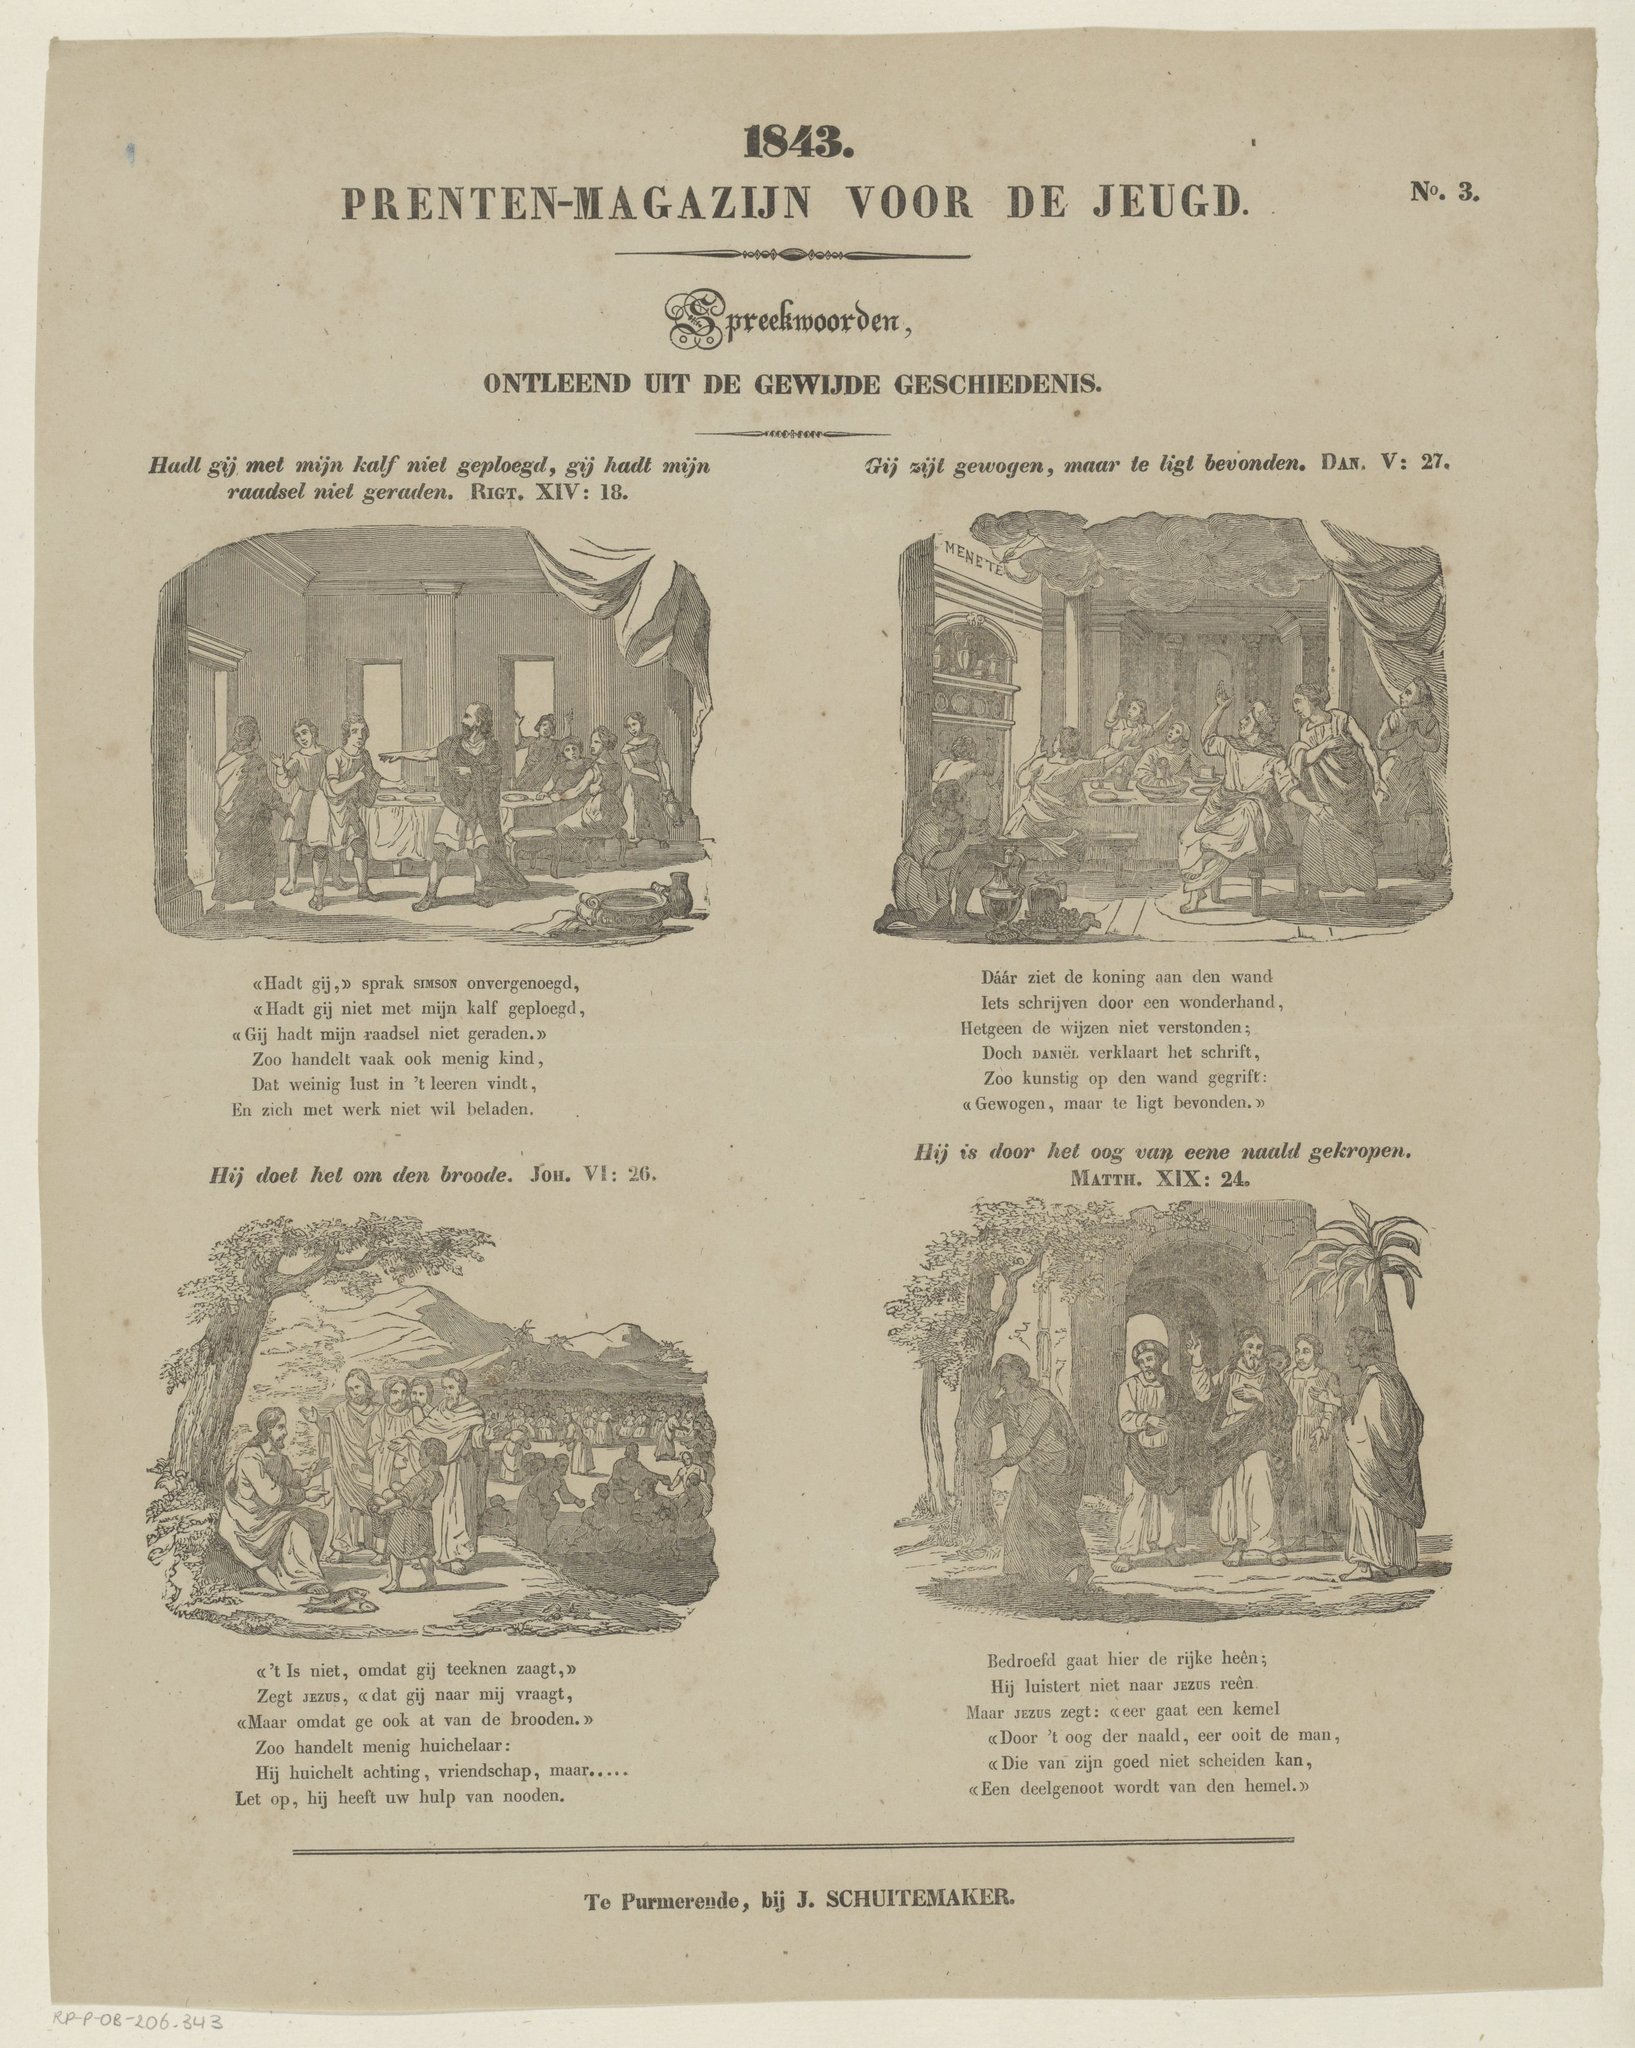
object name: print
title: Ontleend uit de gewijde geschiedenis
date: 1843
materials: paper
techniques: letterpress printing, engraving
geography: netherlands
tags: proverbs, sayings, etc., new testament, old testament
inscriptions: collector's mark: Lugt 2760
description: Blad met 4 verbeeldingen van spreekwoorden, gebaseerd op verhalen uit de Bijbel. Boven elke voorstelling een titel en een verwijzing naar de bijbehorende Bijbeltekst en onder elke voorstelling een zesregelig vers. Genummerd rechtsboven: No. 3.